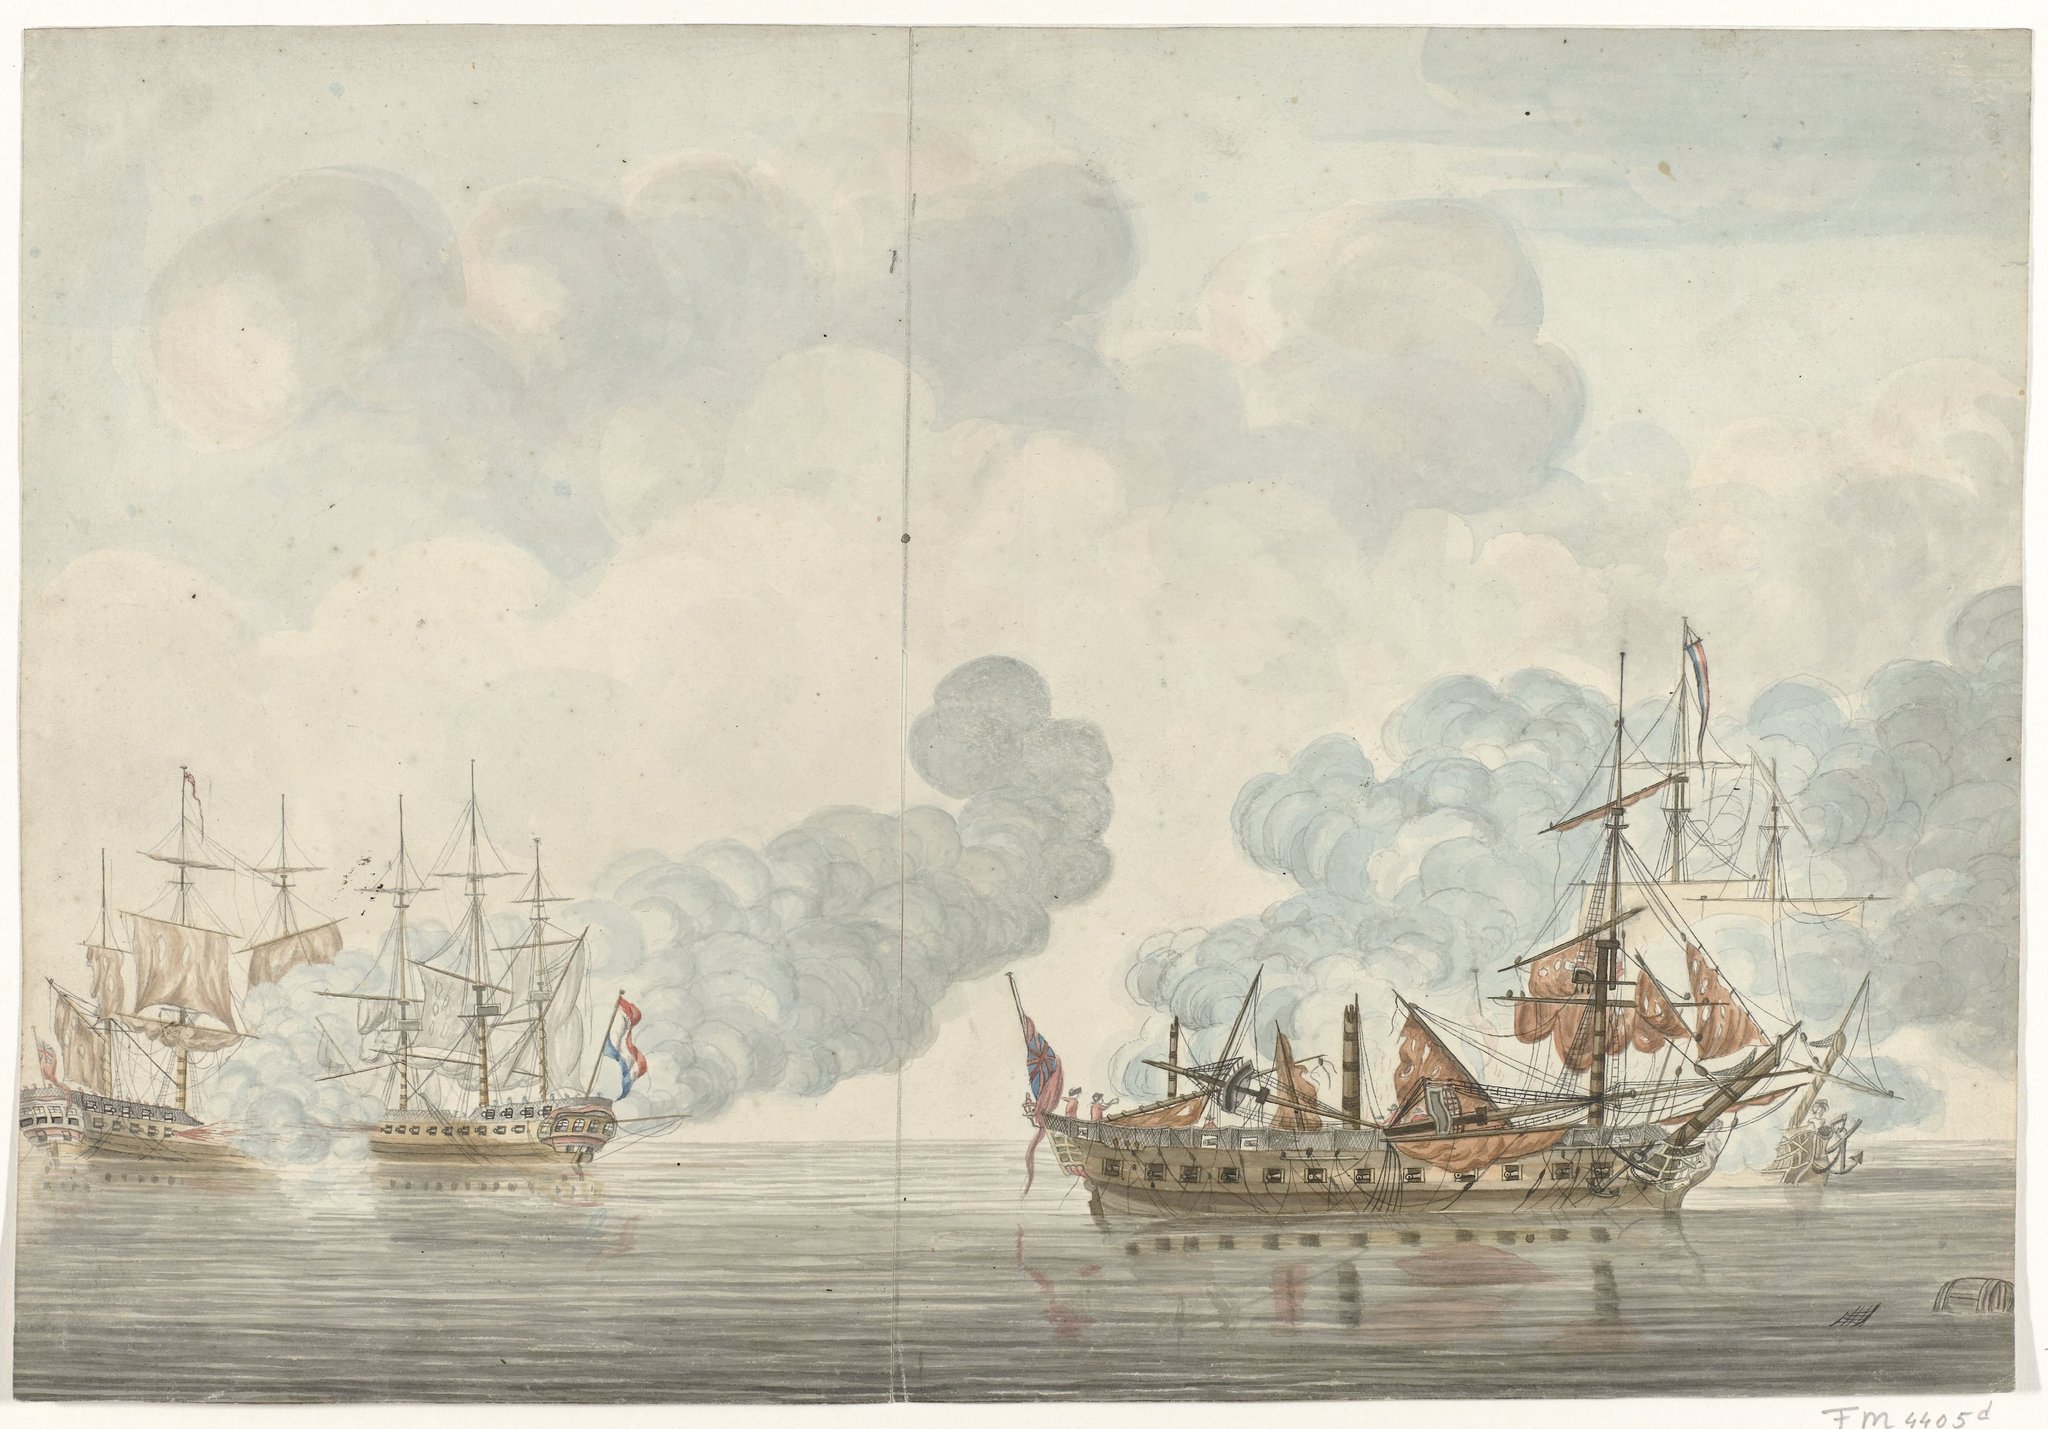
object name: drawing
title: Zeeslag bij Cadiz, 1781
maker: Anonymous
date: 1782-1820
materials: paper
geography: northern netherlands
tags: dordrecht, the hague, naval officer, pieter melvill van carnbee, rotterdam, gerardus oorthuys, battle (+ naval force)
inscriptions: collector's mark: Lugt 2228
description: Zeegevecht bij Cadiz tussen twee Nederlandse fregatten Castor en Den Briel en twee Engelse fregatten Flora en Crescent, 30 mei 1781. Op de achterzijde een schets van twee figuren bij een antieke tempel.